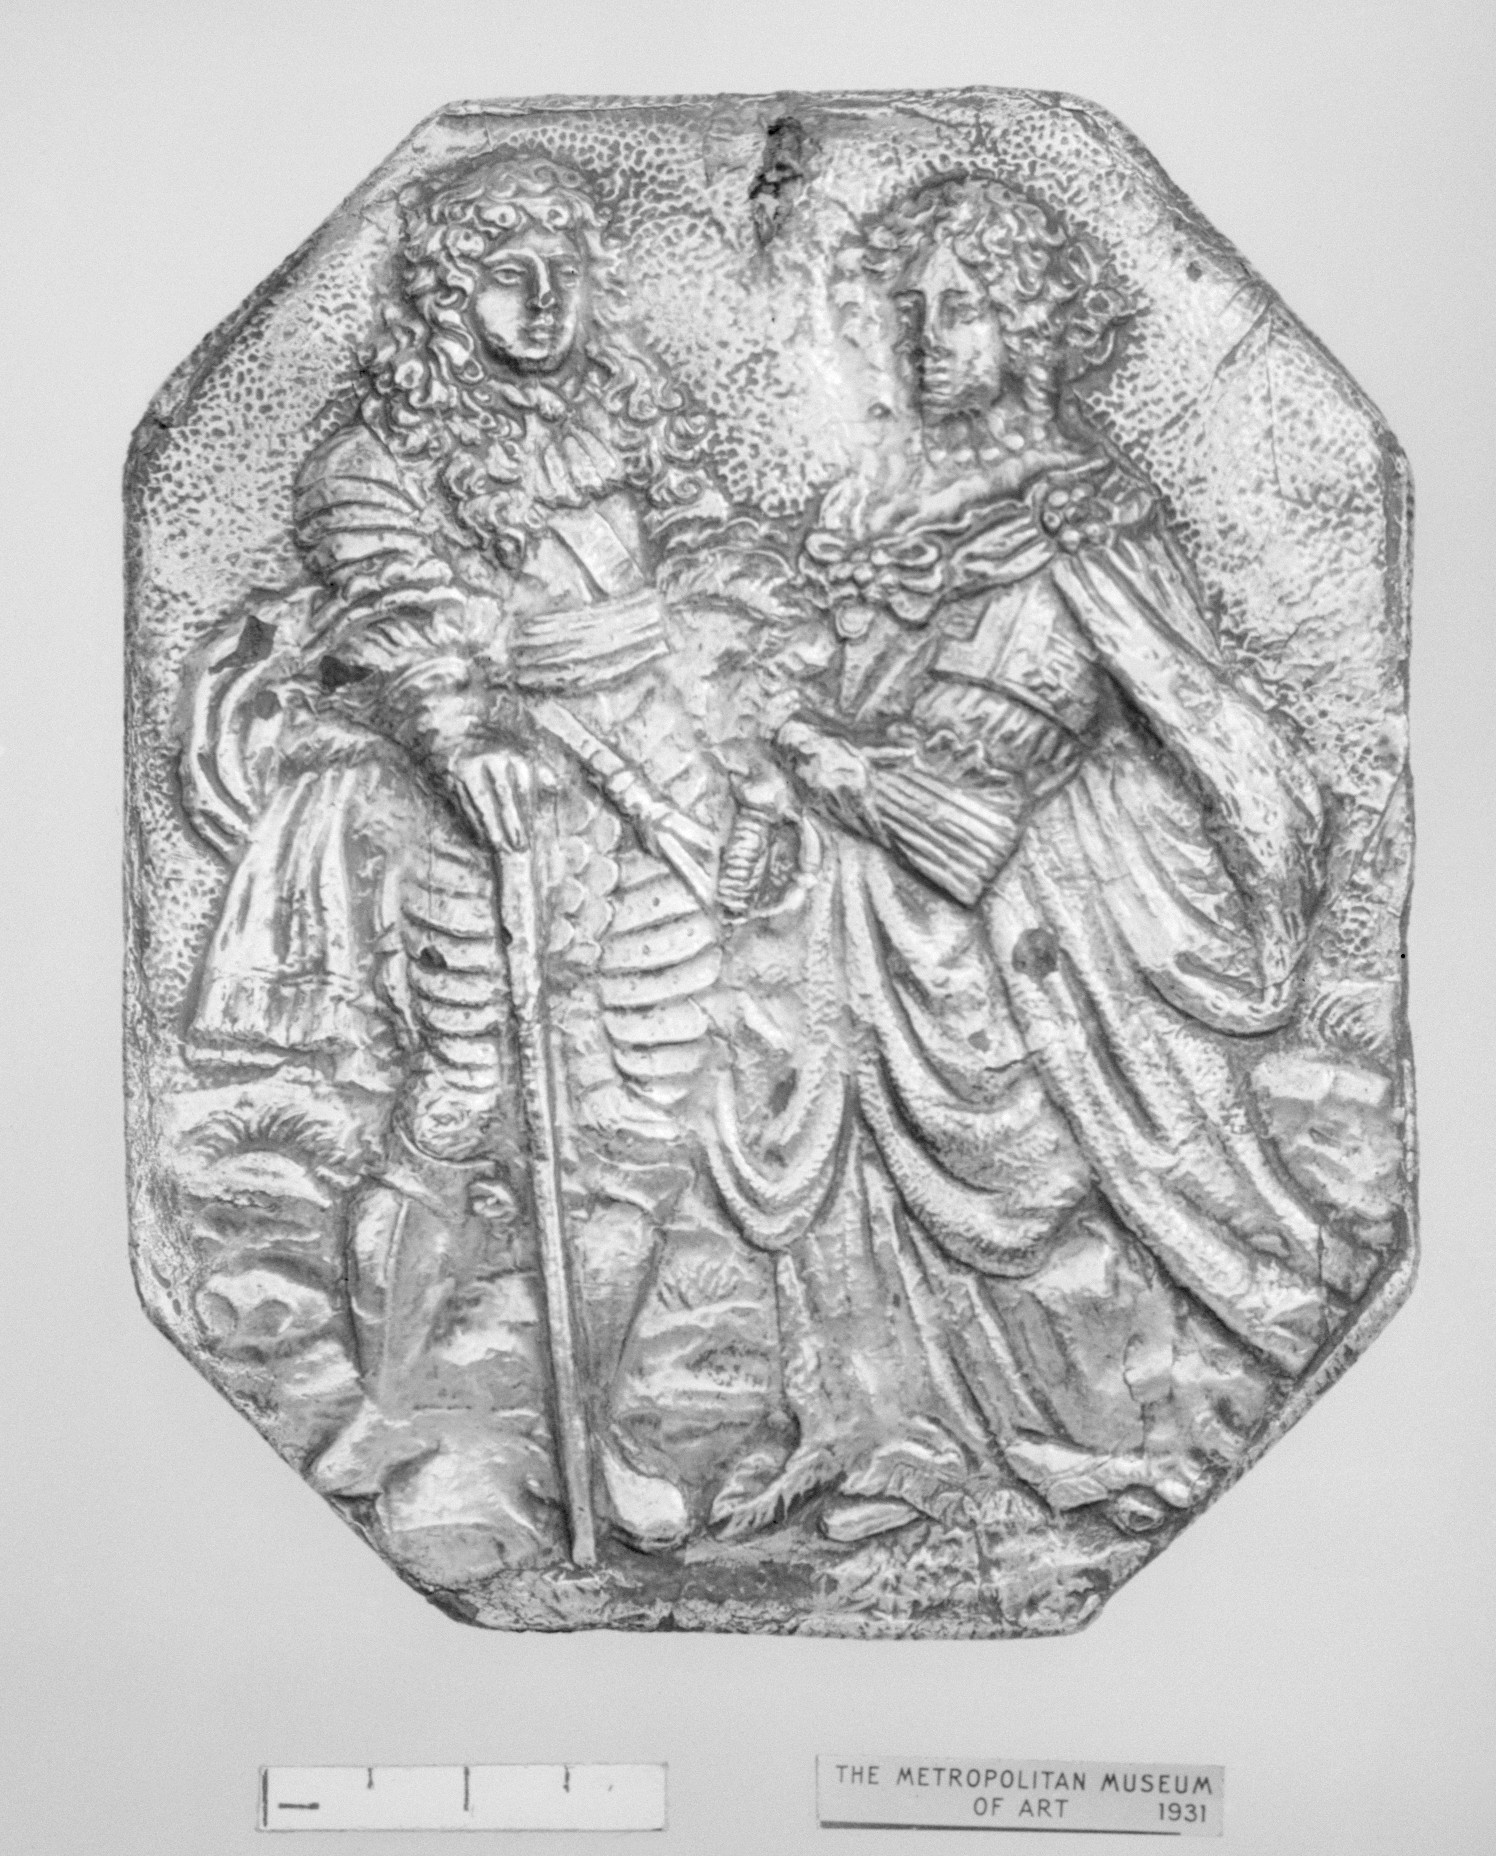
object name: mirror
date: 1650-1700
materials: silver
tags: men,women